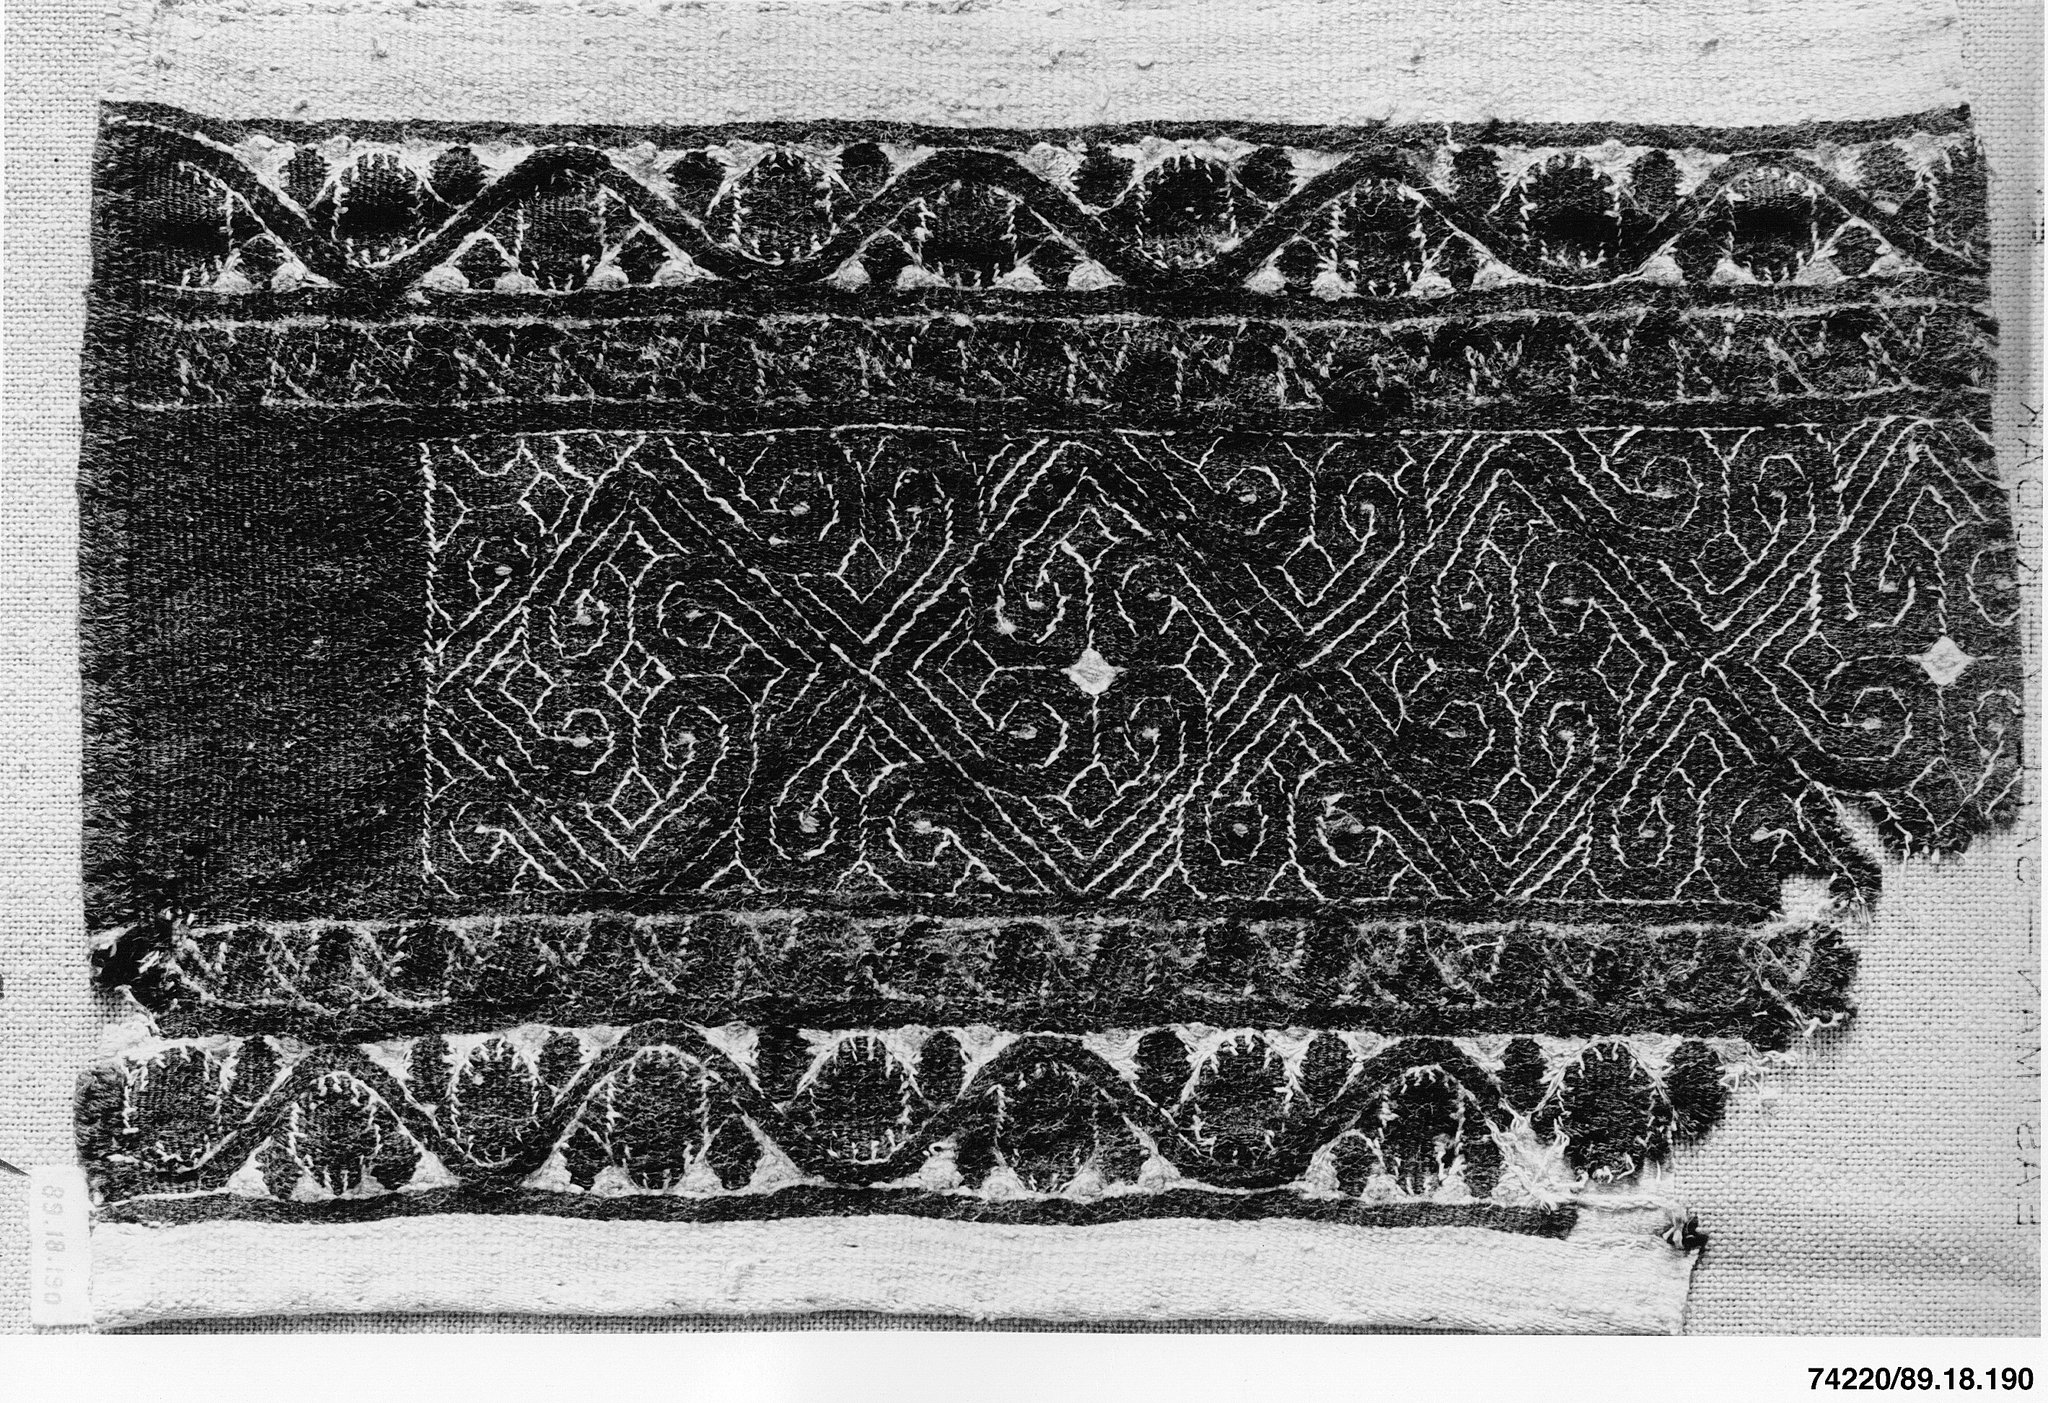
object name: textile fragment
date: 201-400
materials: linen, wool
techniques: weave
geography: egypt